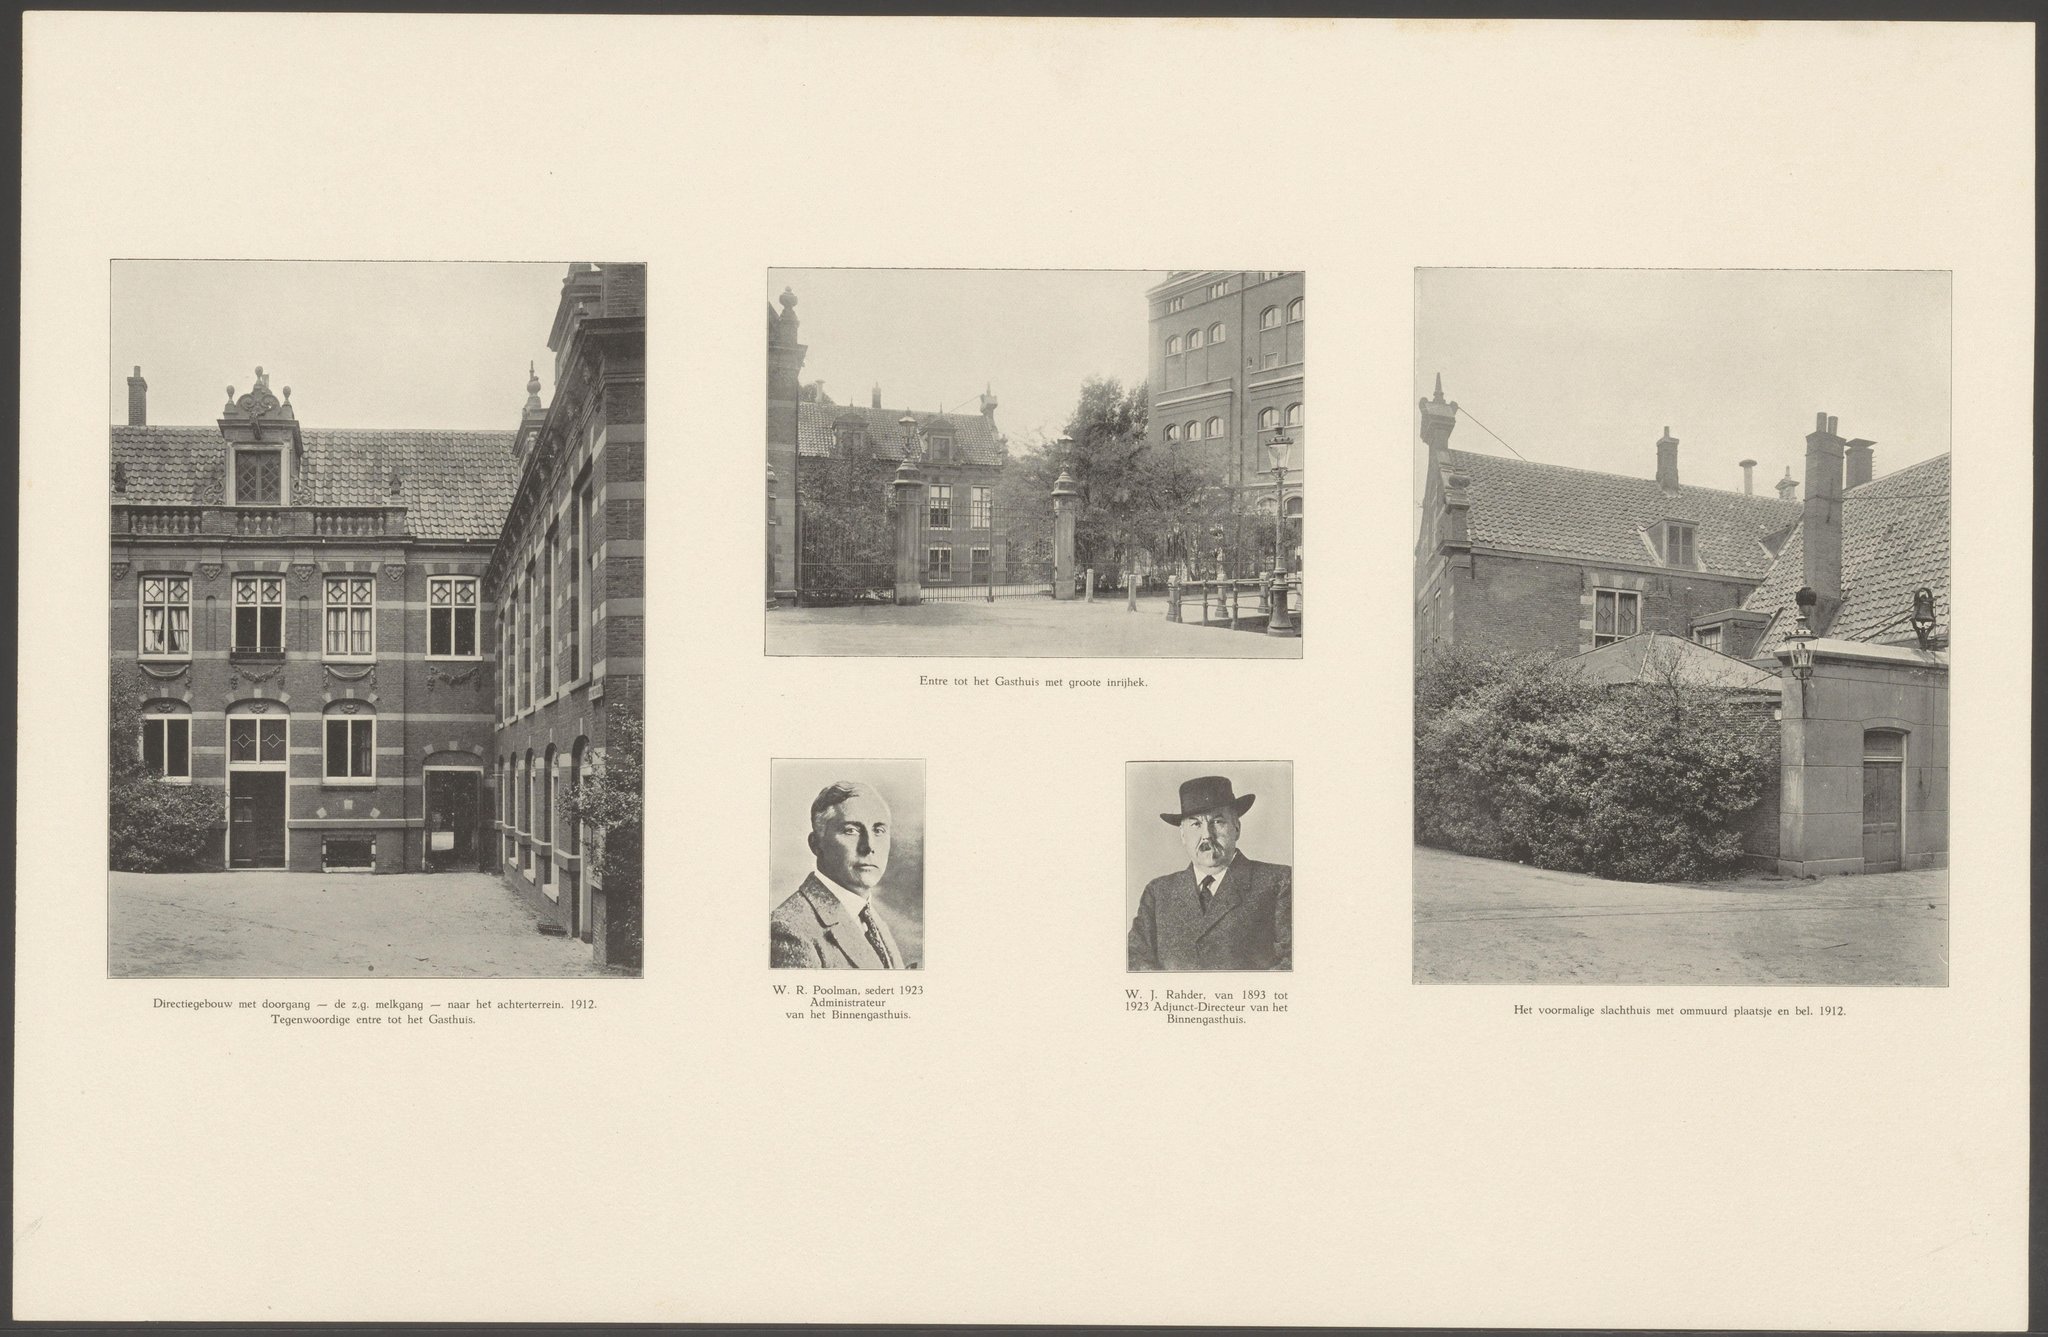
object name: photomechanical print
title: Voorstellingen rond het Binnengasthuis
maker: Anonymous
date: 1912-1970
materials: paper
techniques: letterpress printing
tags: hospital, maps of cities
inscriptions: collector's mark: Lugt 1641b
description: Drie losse voorstellingen van het Binnengasthuis, met het directiegebouw, de entree en het voormalige slachthuis. Onderaan twee portretten W.R, Poolman en W.J. Rahder. Onderwerpsrubriek binnen de Atlas Amsterdam: Armwezen en liefdadige instellingen: I. Stadsinrichtingen: Binnengasthuis.